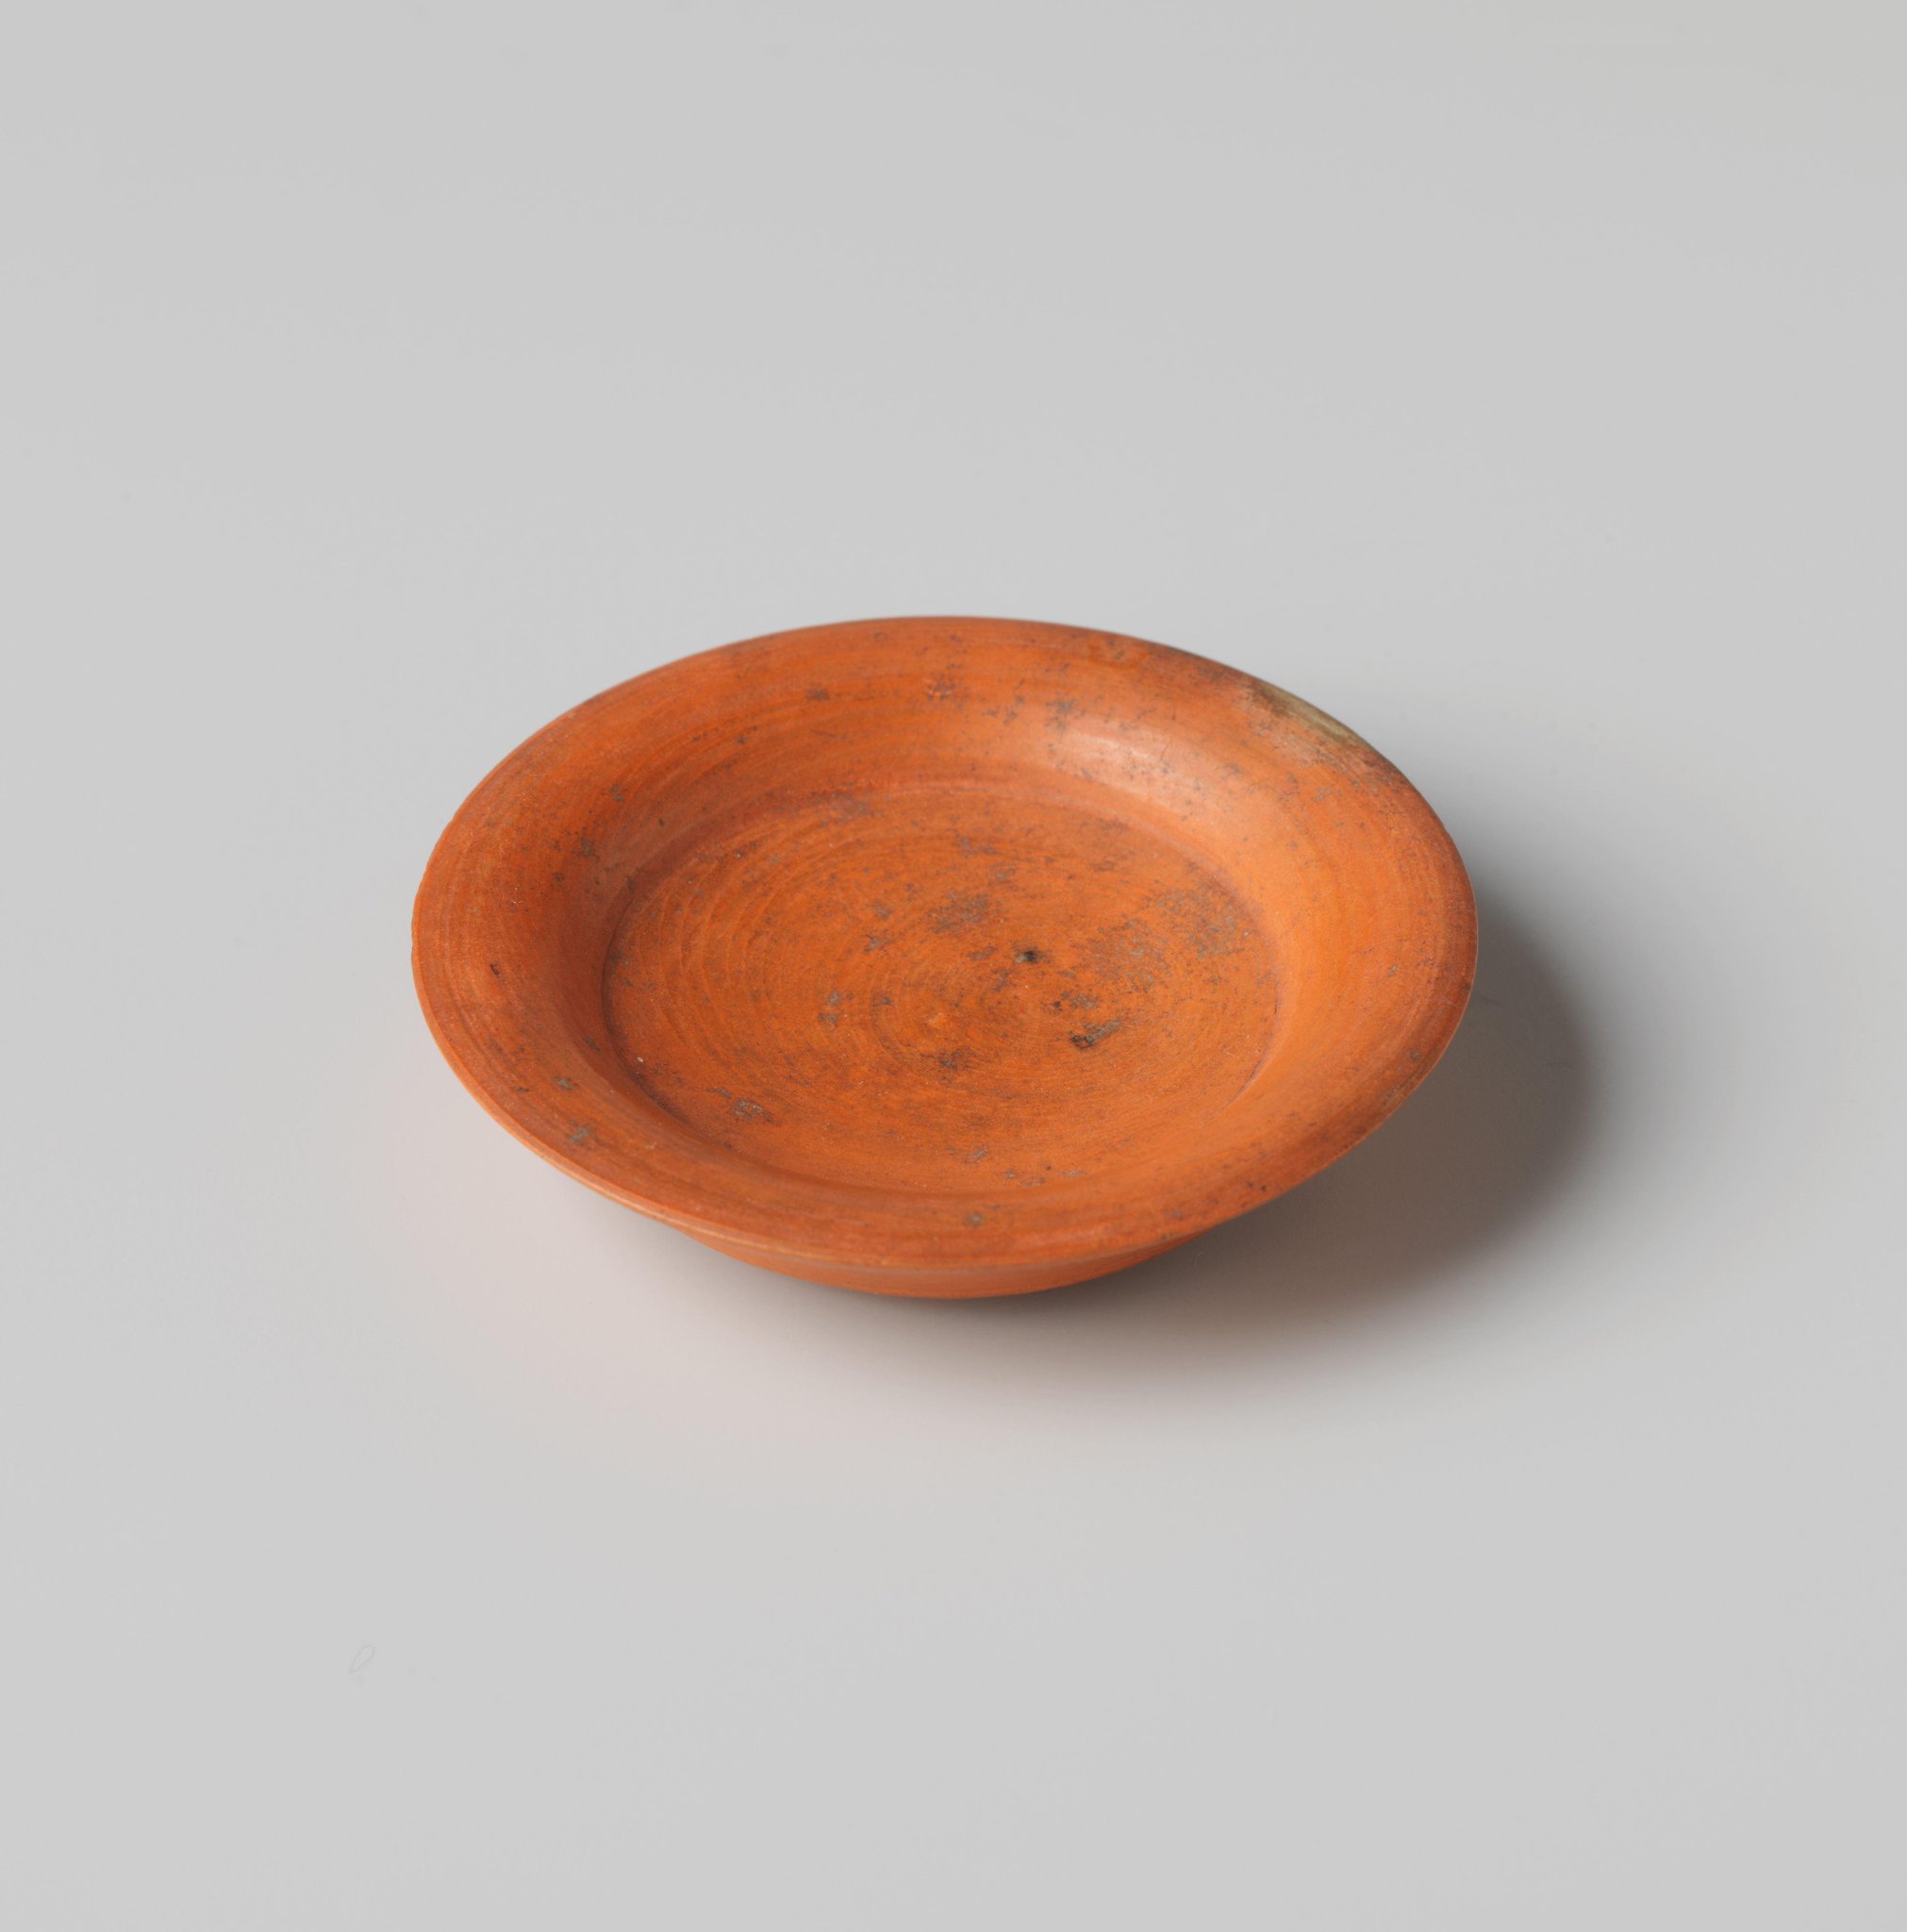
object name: platter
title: Schotel, roodgeverfd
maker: Anonymous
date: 1675-1700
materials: wood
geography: amsterdam